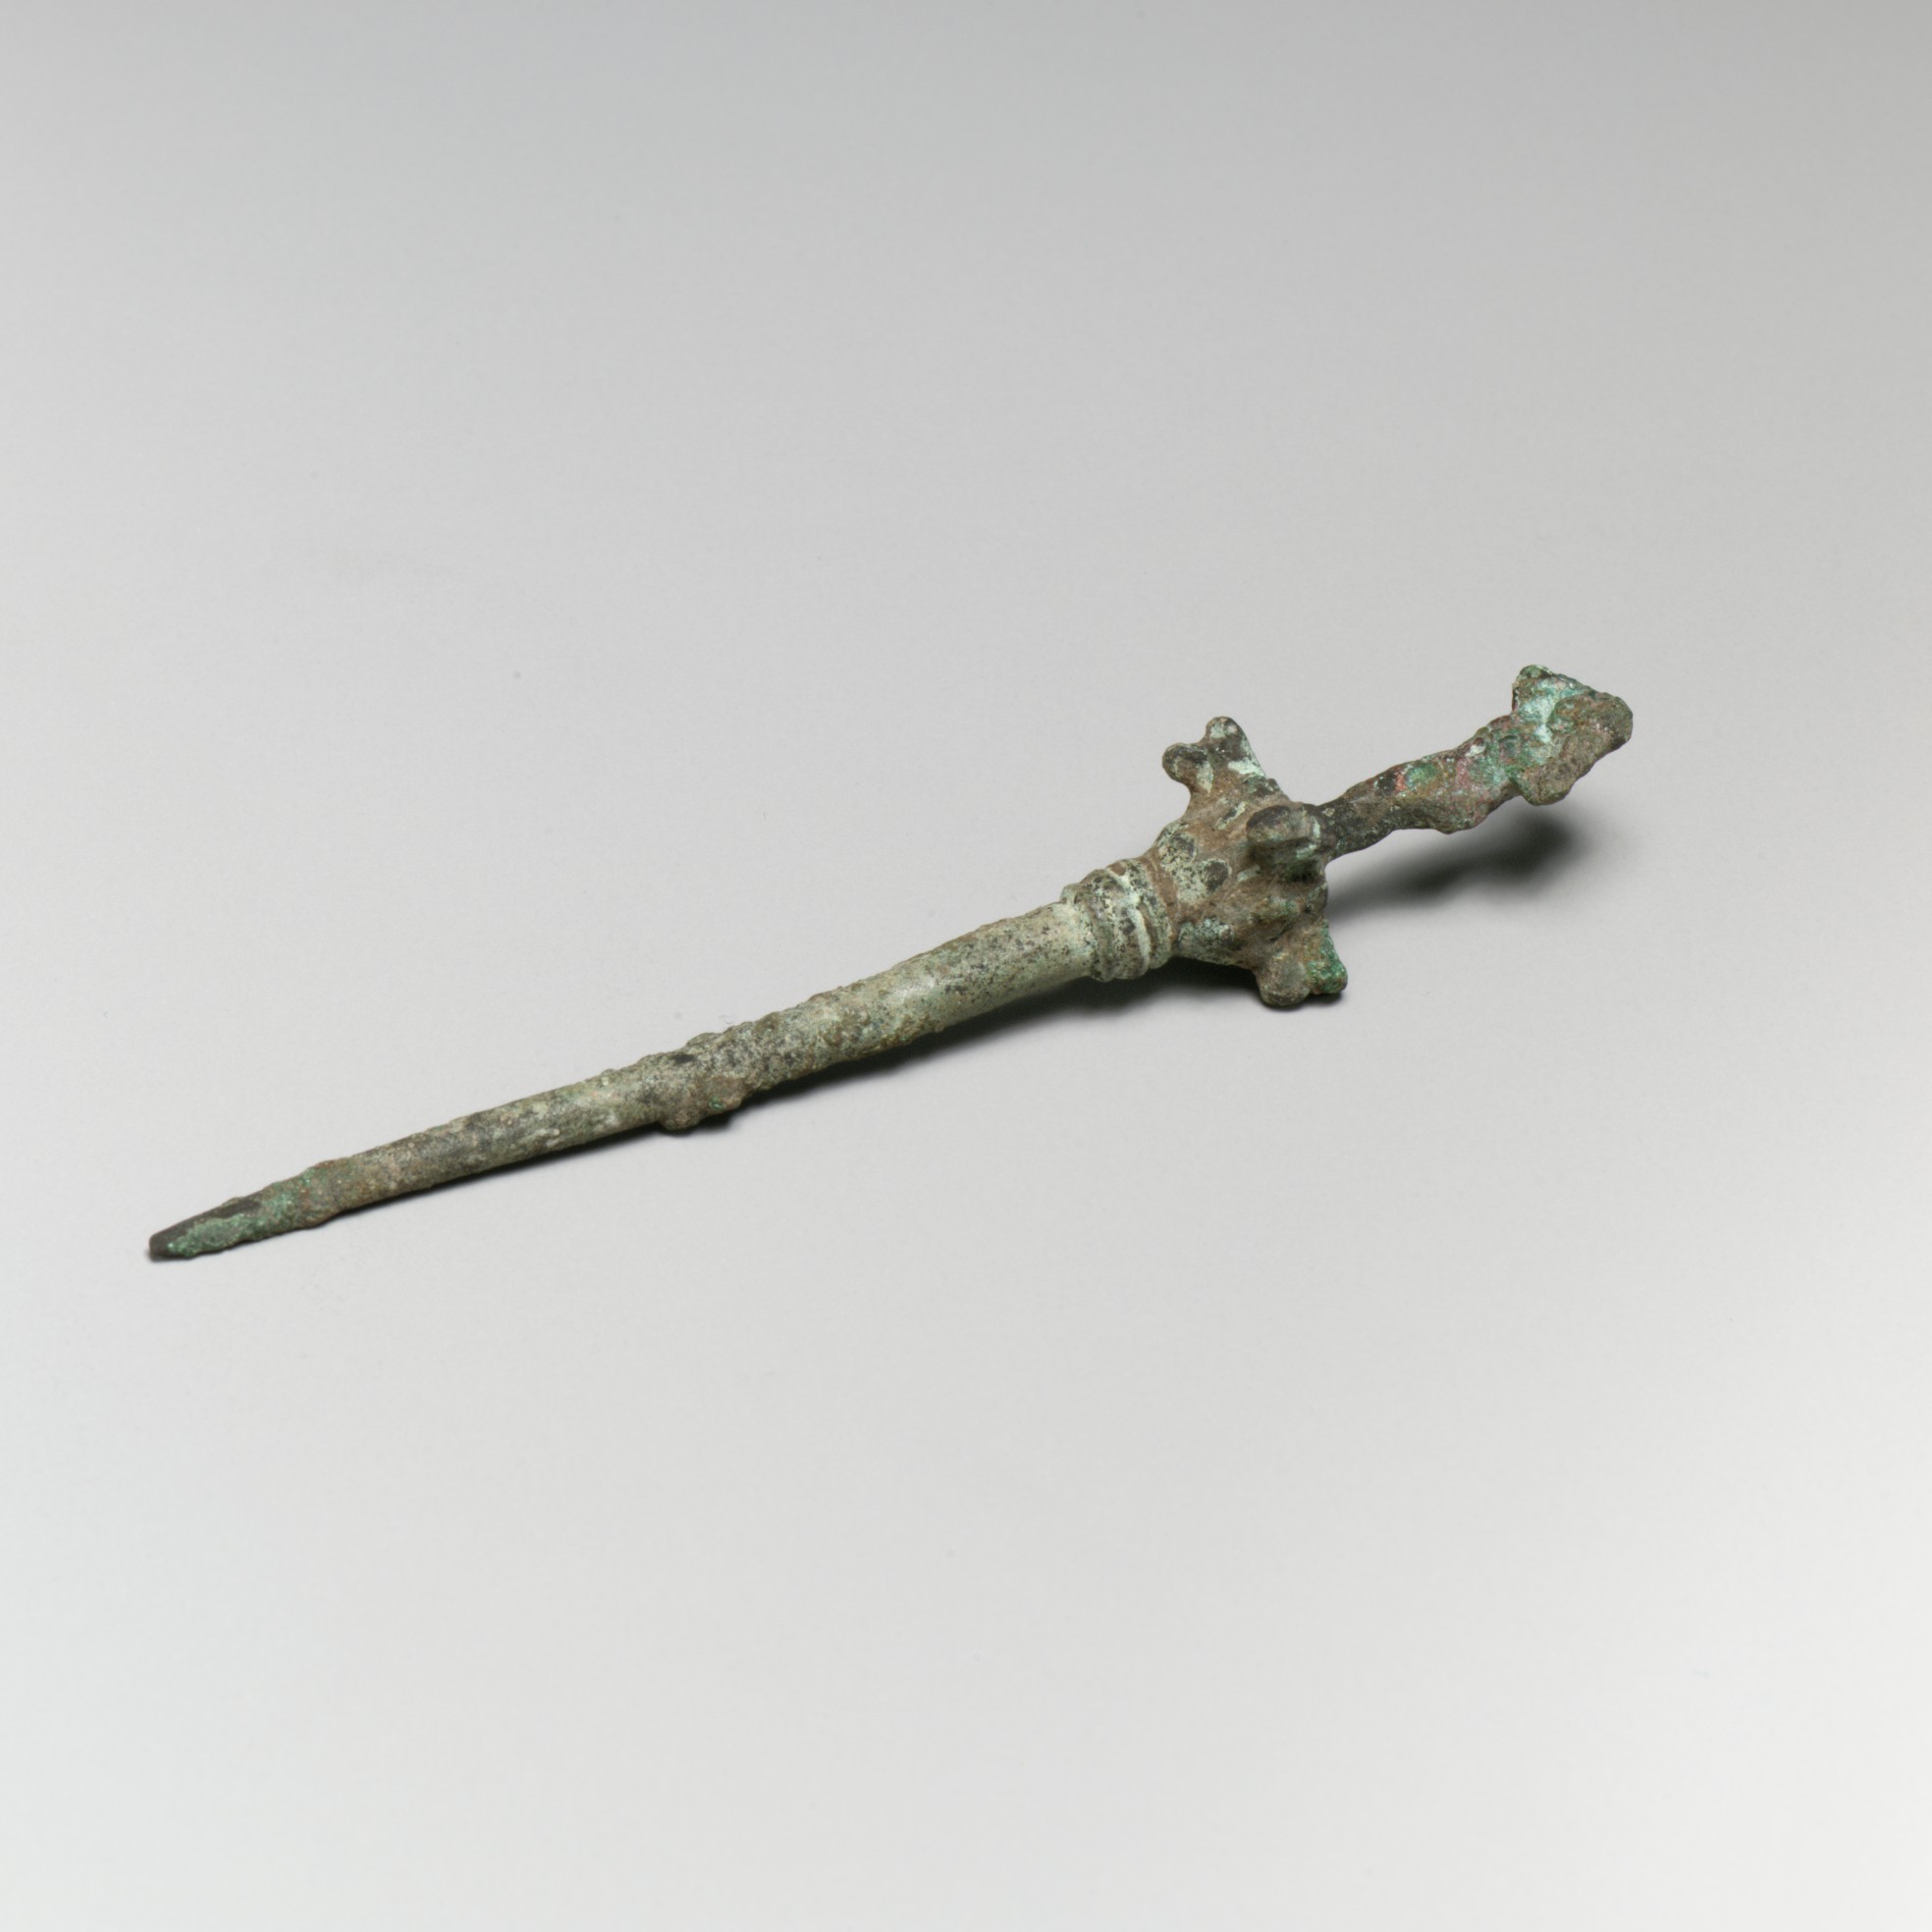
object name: pin with head of aphrodite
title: Bronze pin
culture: greek or roman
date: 1-100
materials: bronze